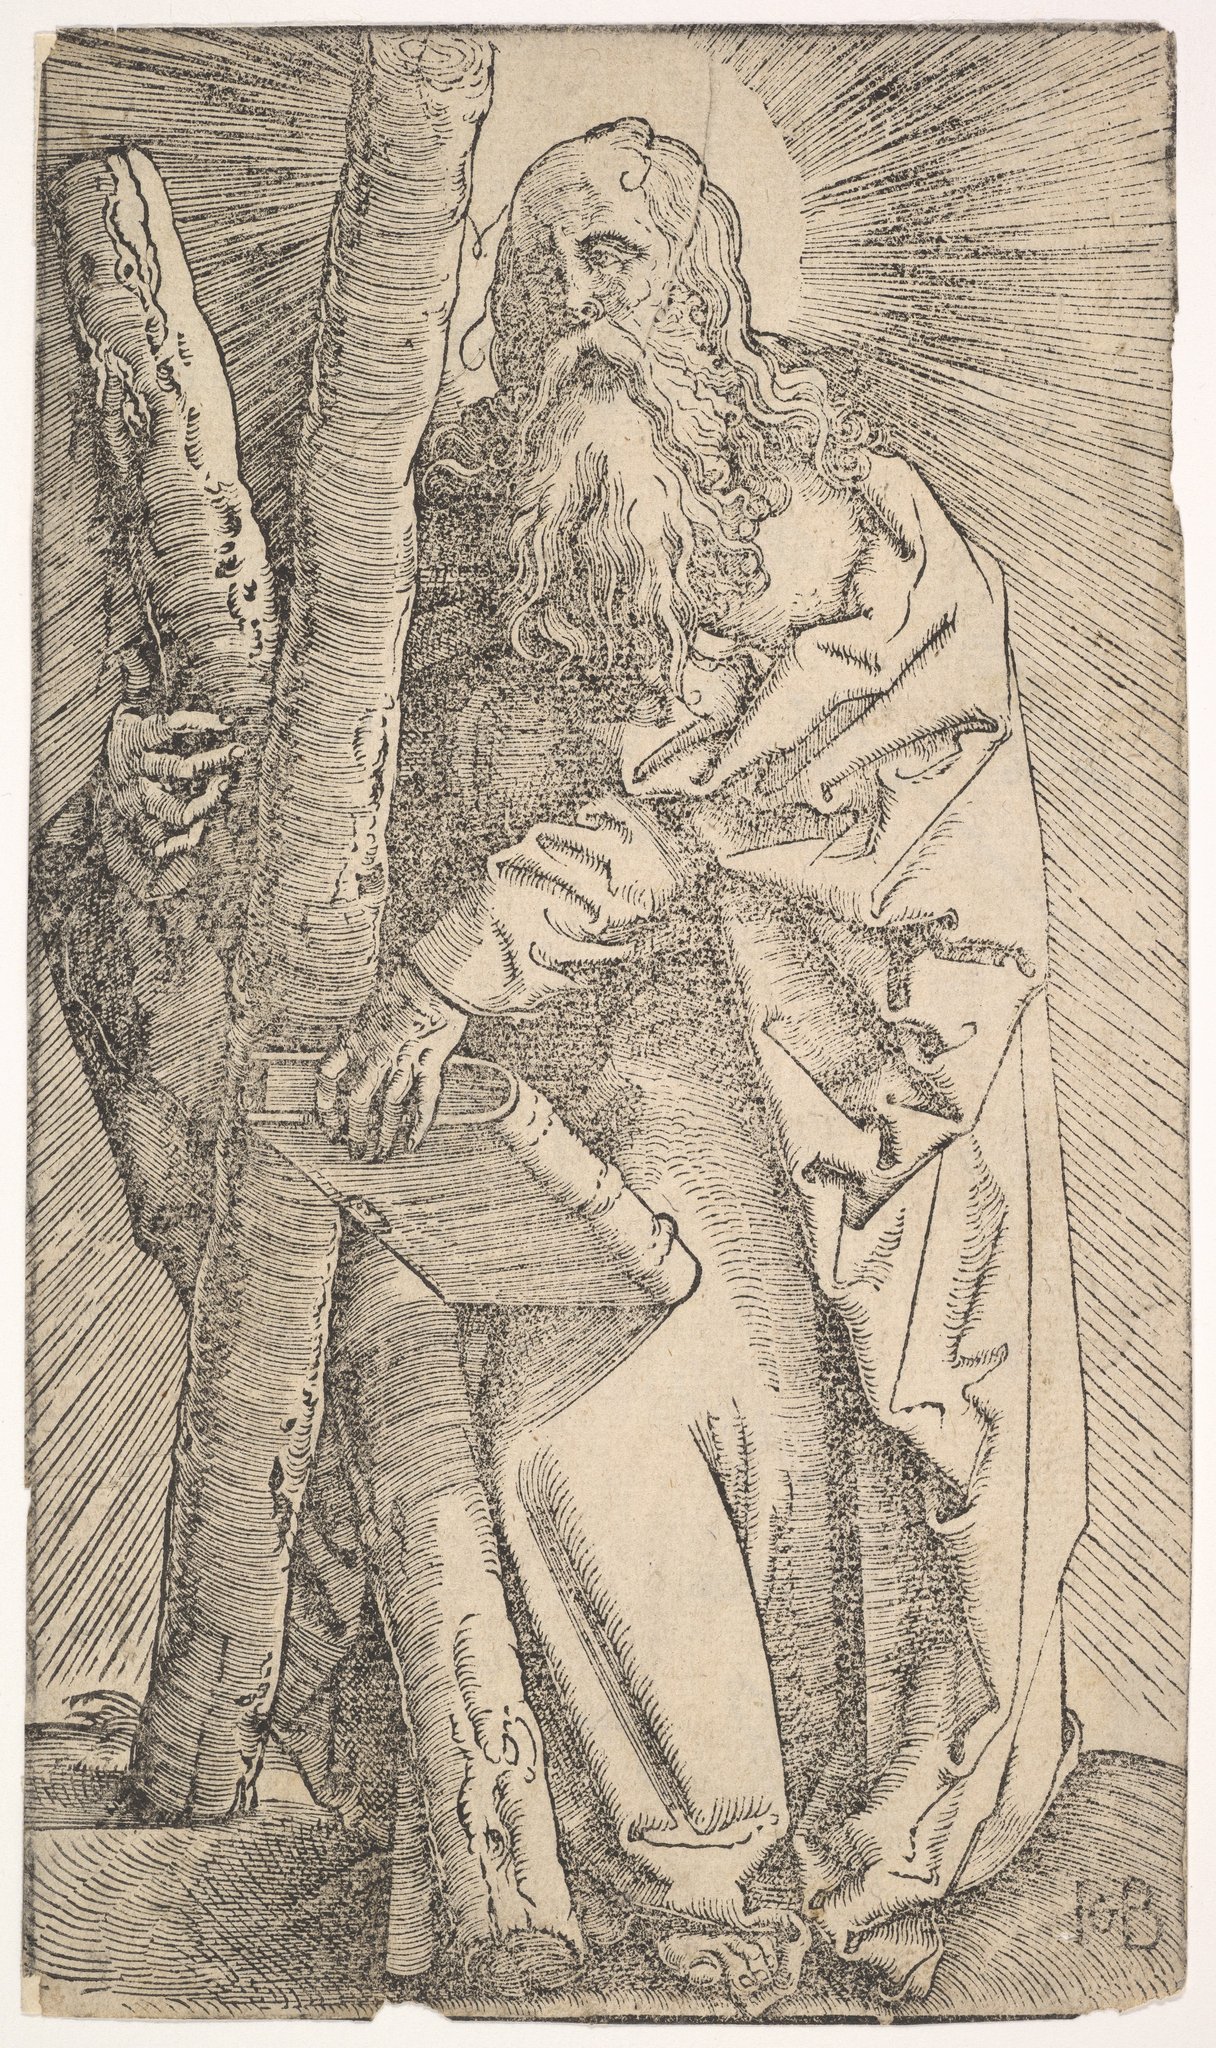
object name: print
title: St. Andrew from Christ and the Apostles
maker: hans baldung (called hans baldung grien)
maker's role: artist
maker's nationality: german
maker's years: 1484-1545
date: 1519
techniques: woodcut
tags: saints